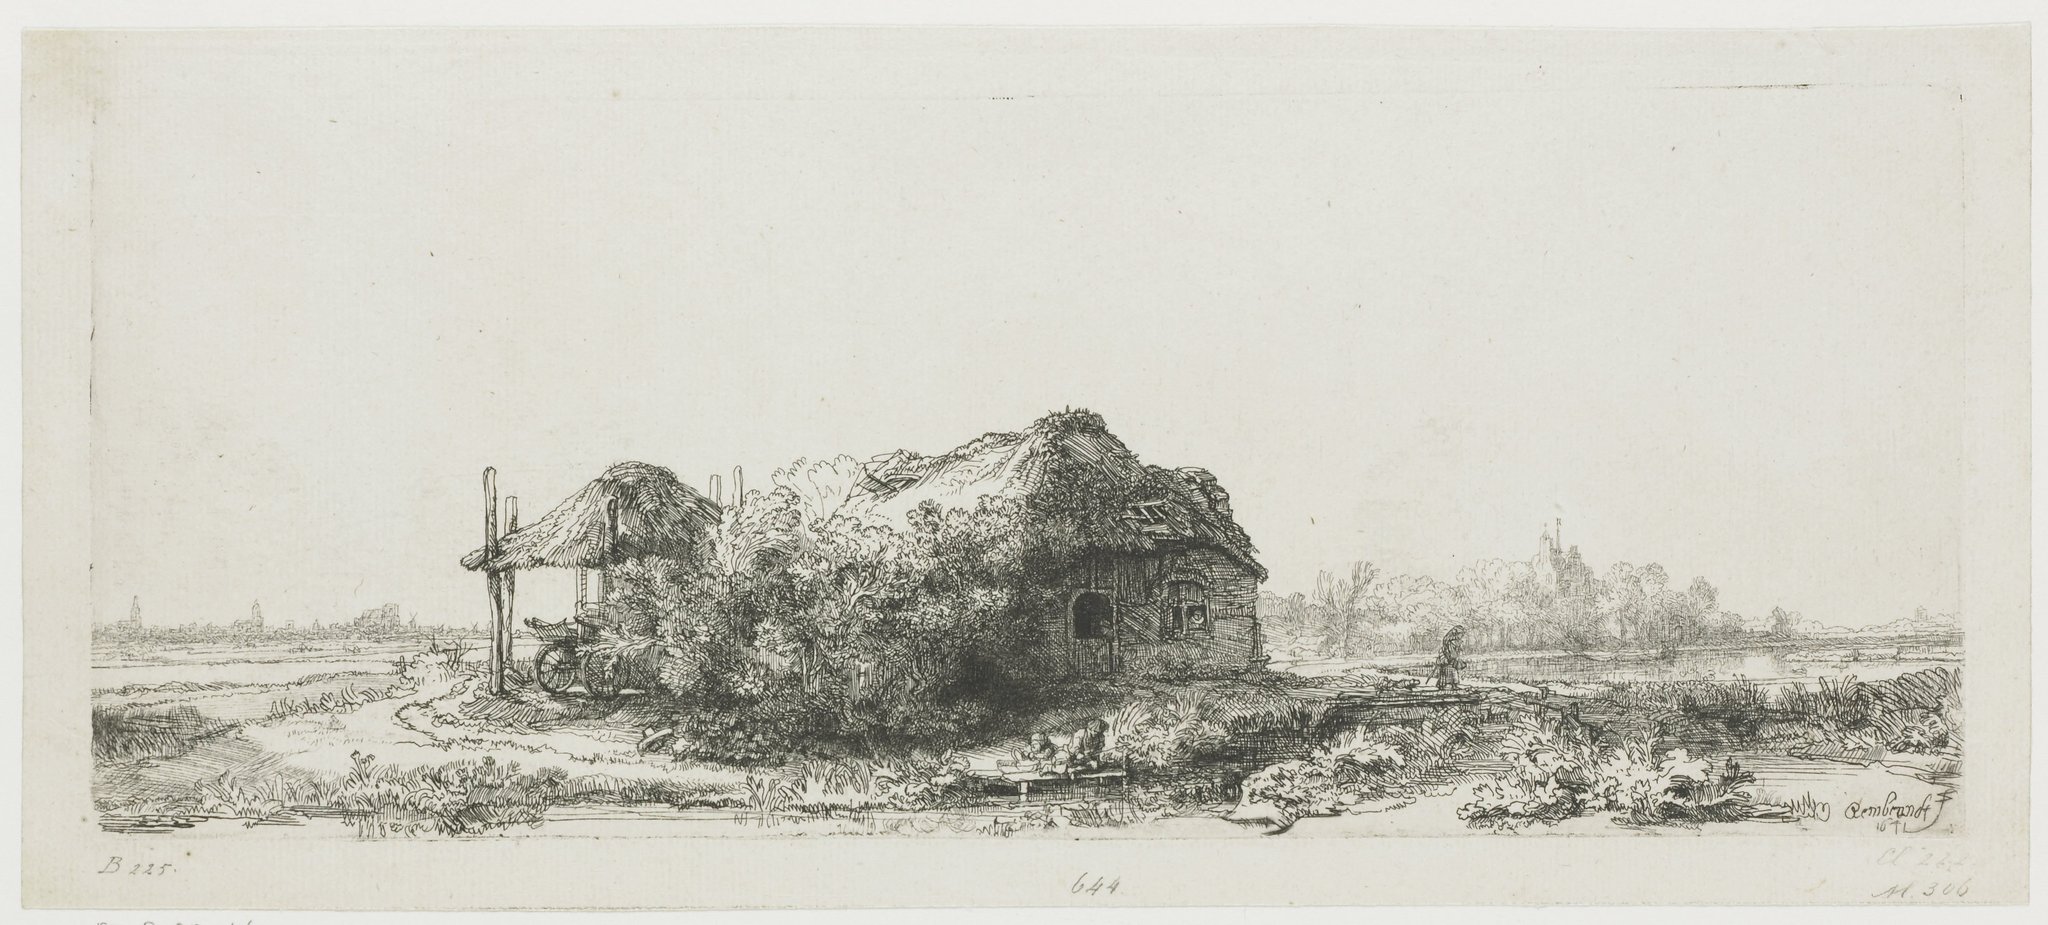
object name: print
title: Landscape with cottages and a hay barn: oblong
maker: rembrandt van rijn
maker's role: draughtsman, painter, print maker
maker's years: 1606-1669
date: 1641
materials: paper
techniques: drypoint, etching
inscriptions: signature and date: ‘Rembrandt f 1641’, collector's mark: Lugt 240